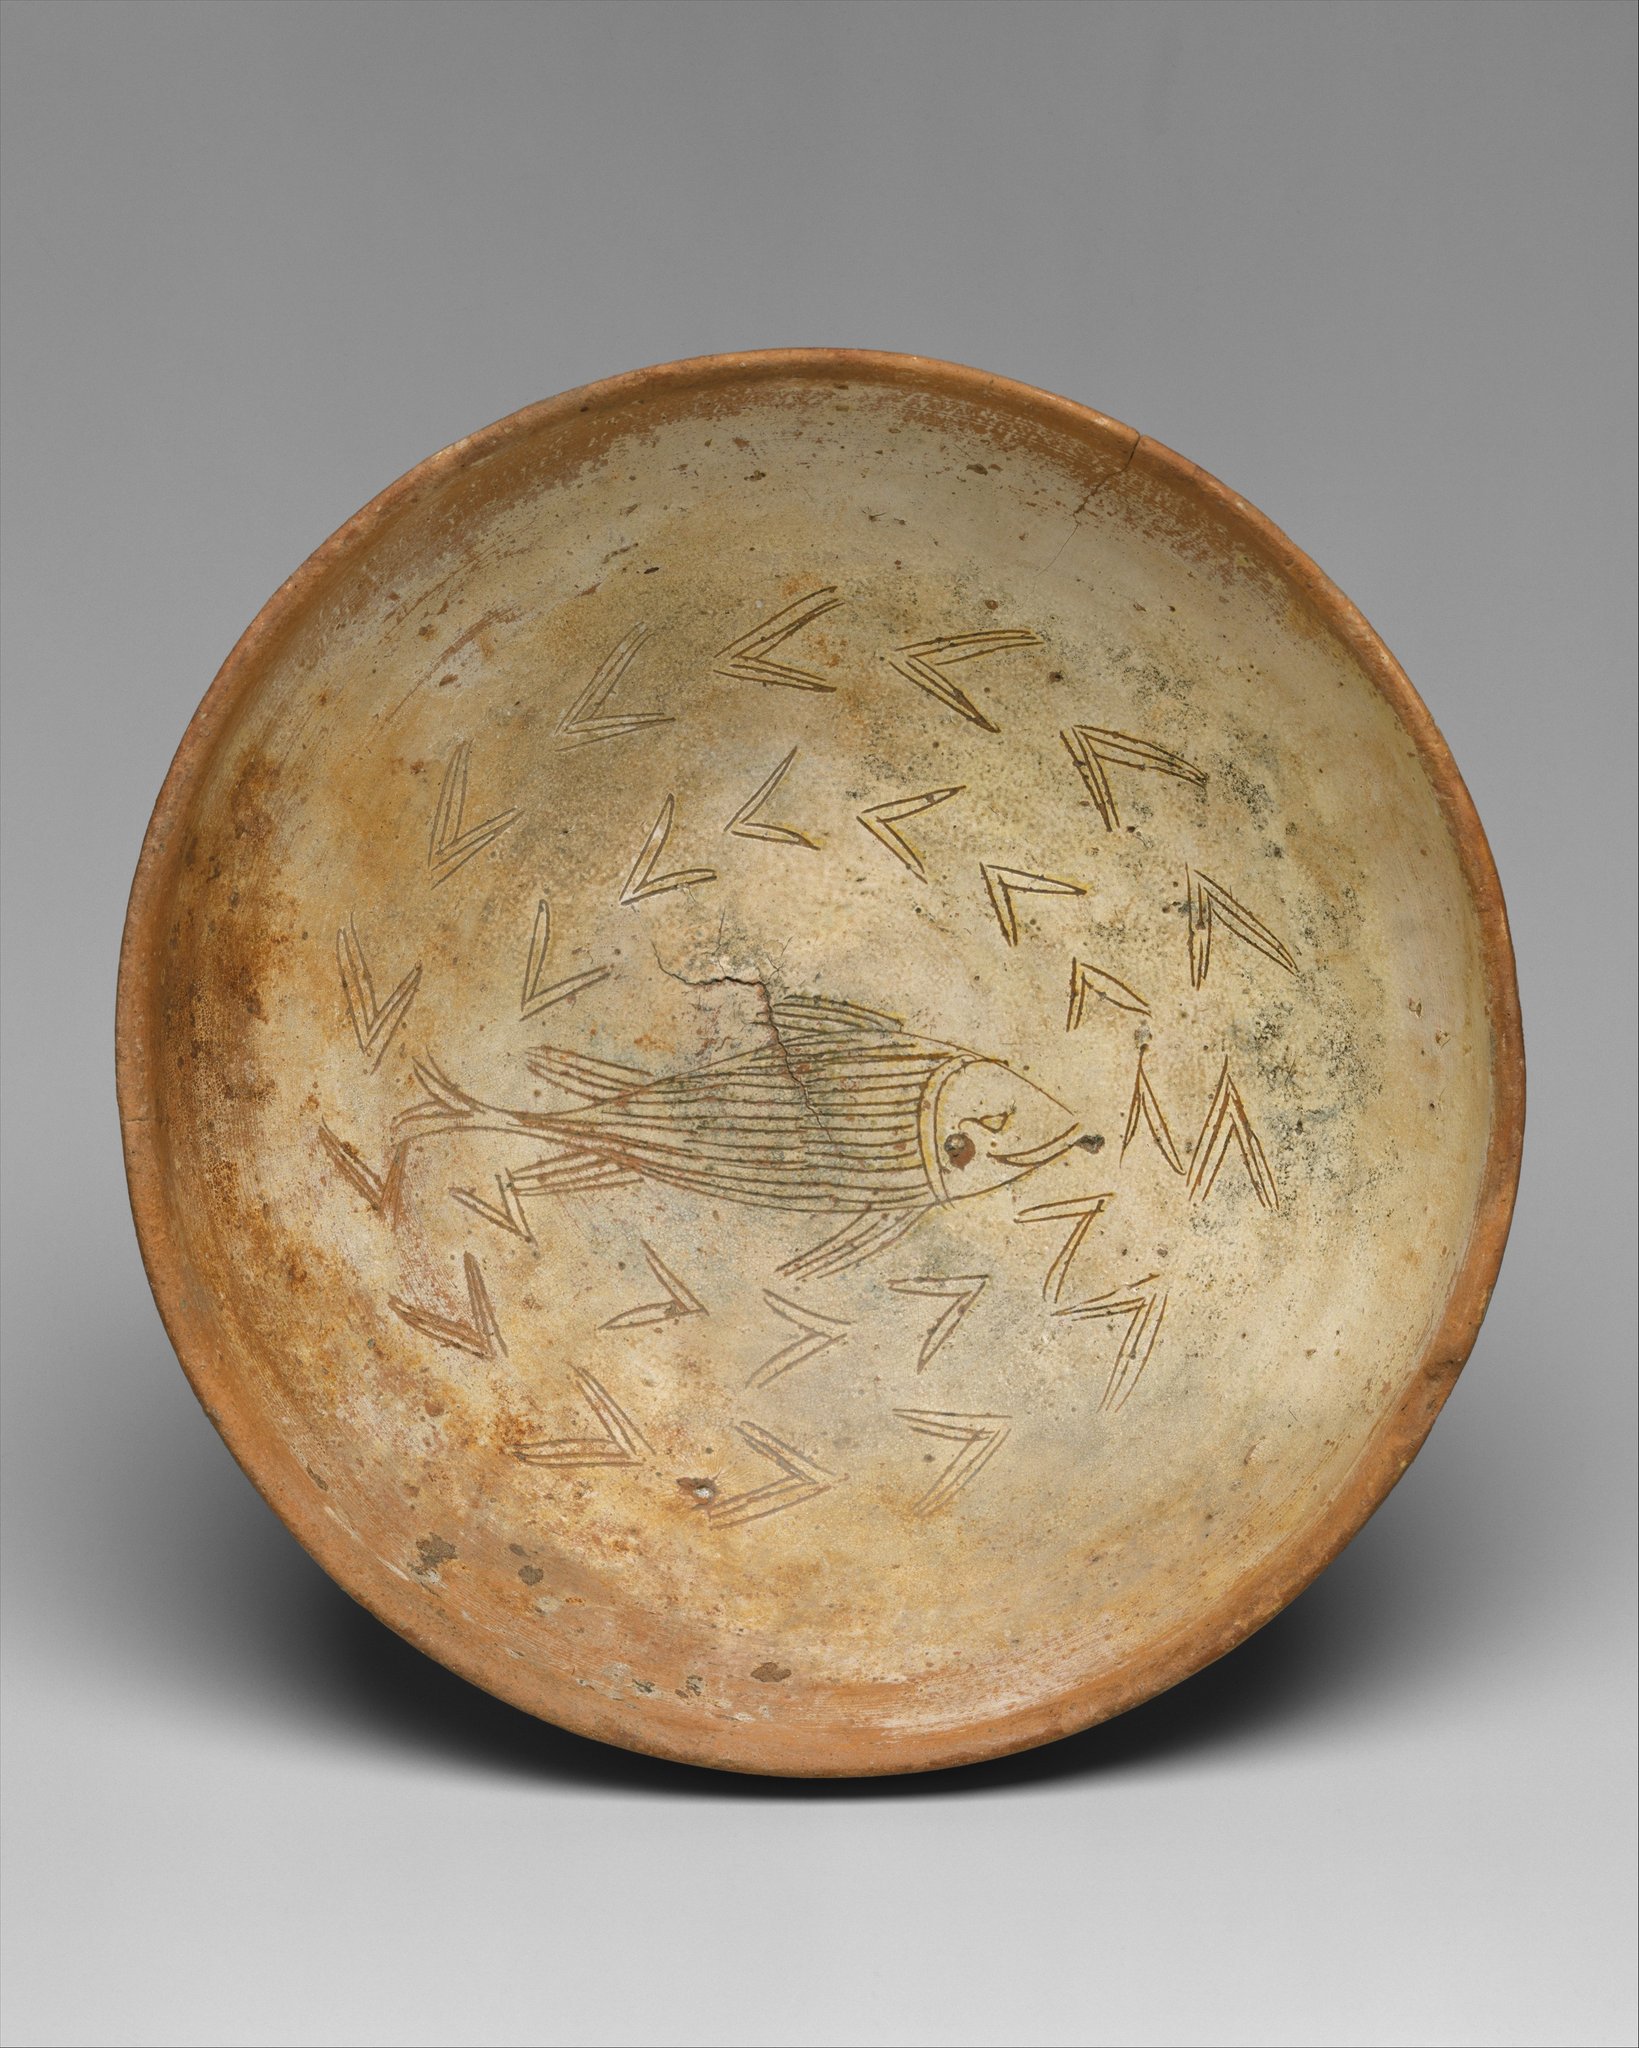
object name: bowl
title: Bowl with Fish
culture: byzantine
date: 1000-1300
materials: earthenware, glaze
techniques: engraving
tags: fish